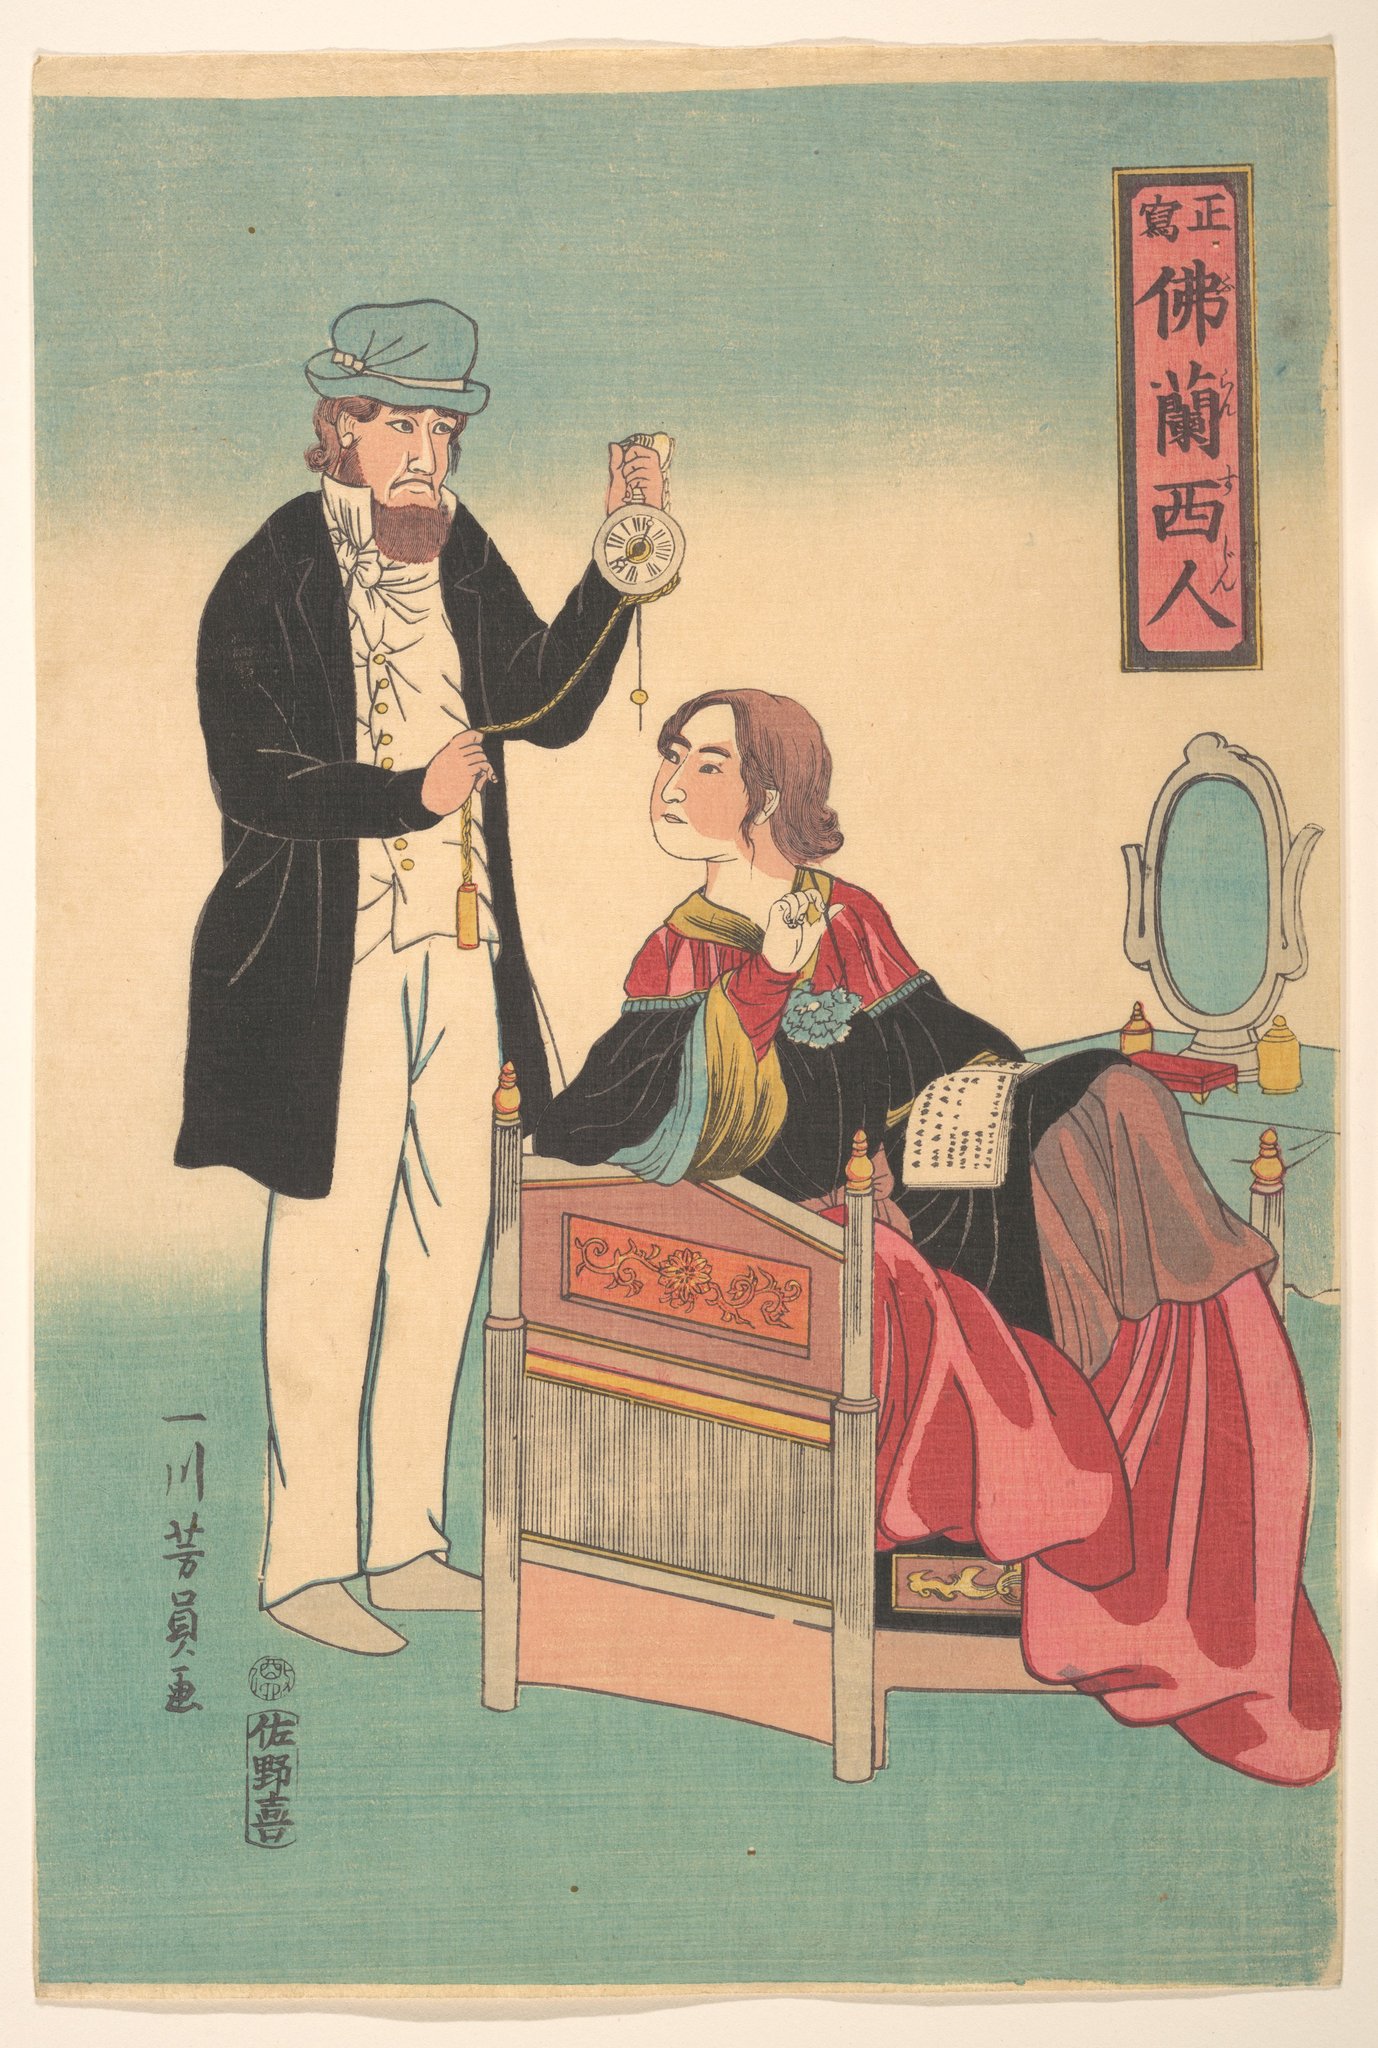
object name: print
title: French Couple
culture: japanese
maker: utagawa yoshikazu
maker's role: artist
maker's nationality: japanese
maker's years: 1845-1870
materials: ink, paper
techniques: woodblock print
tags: books,watches,couples,chairs,mirrors